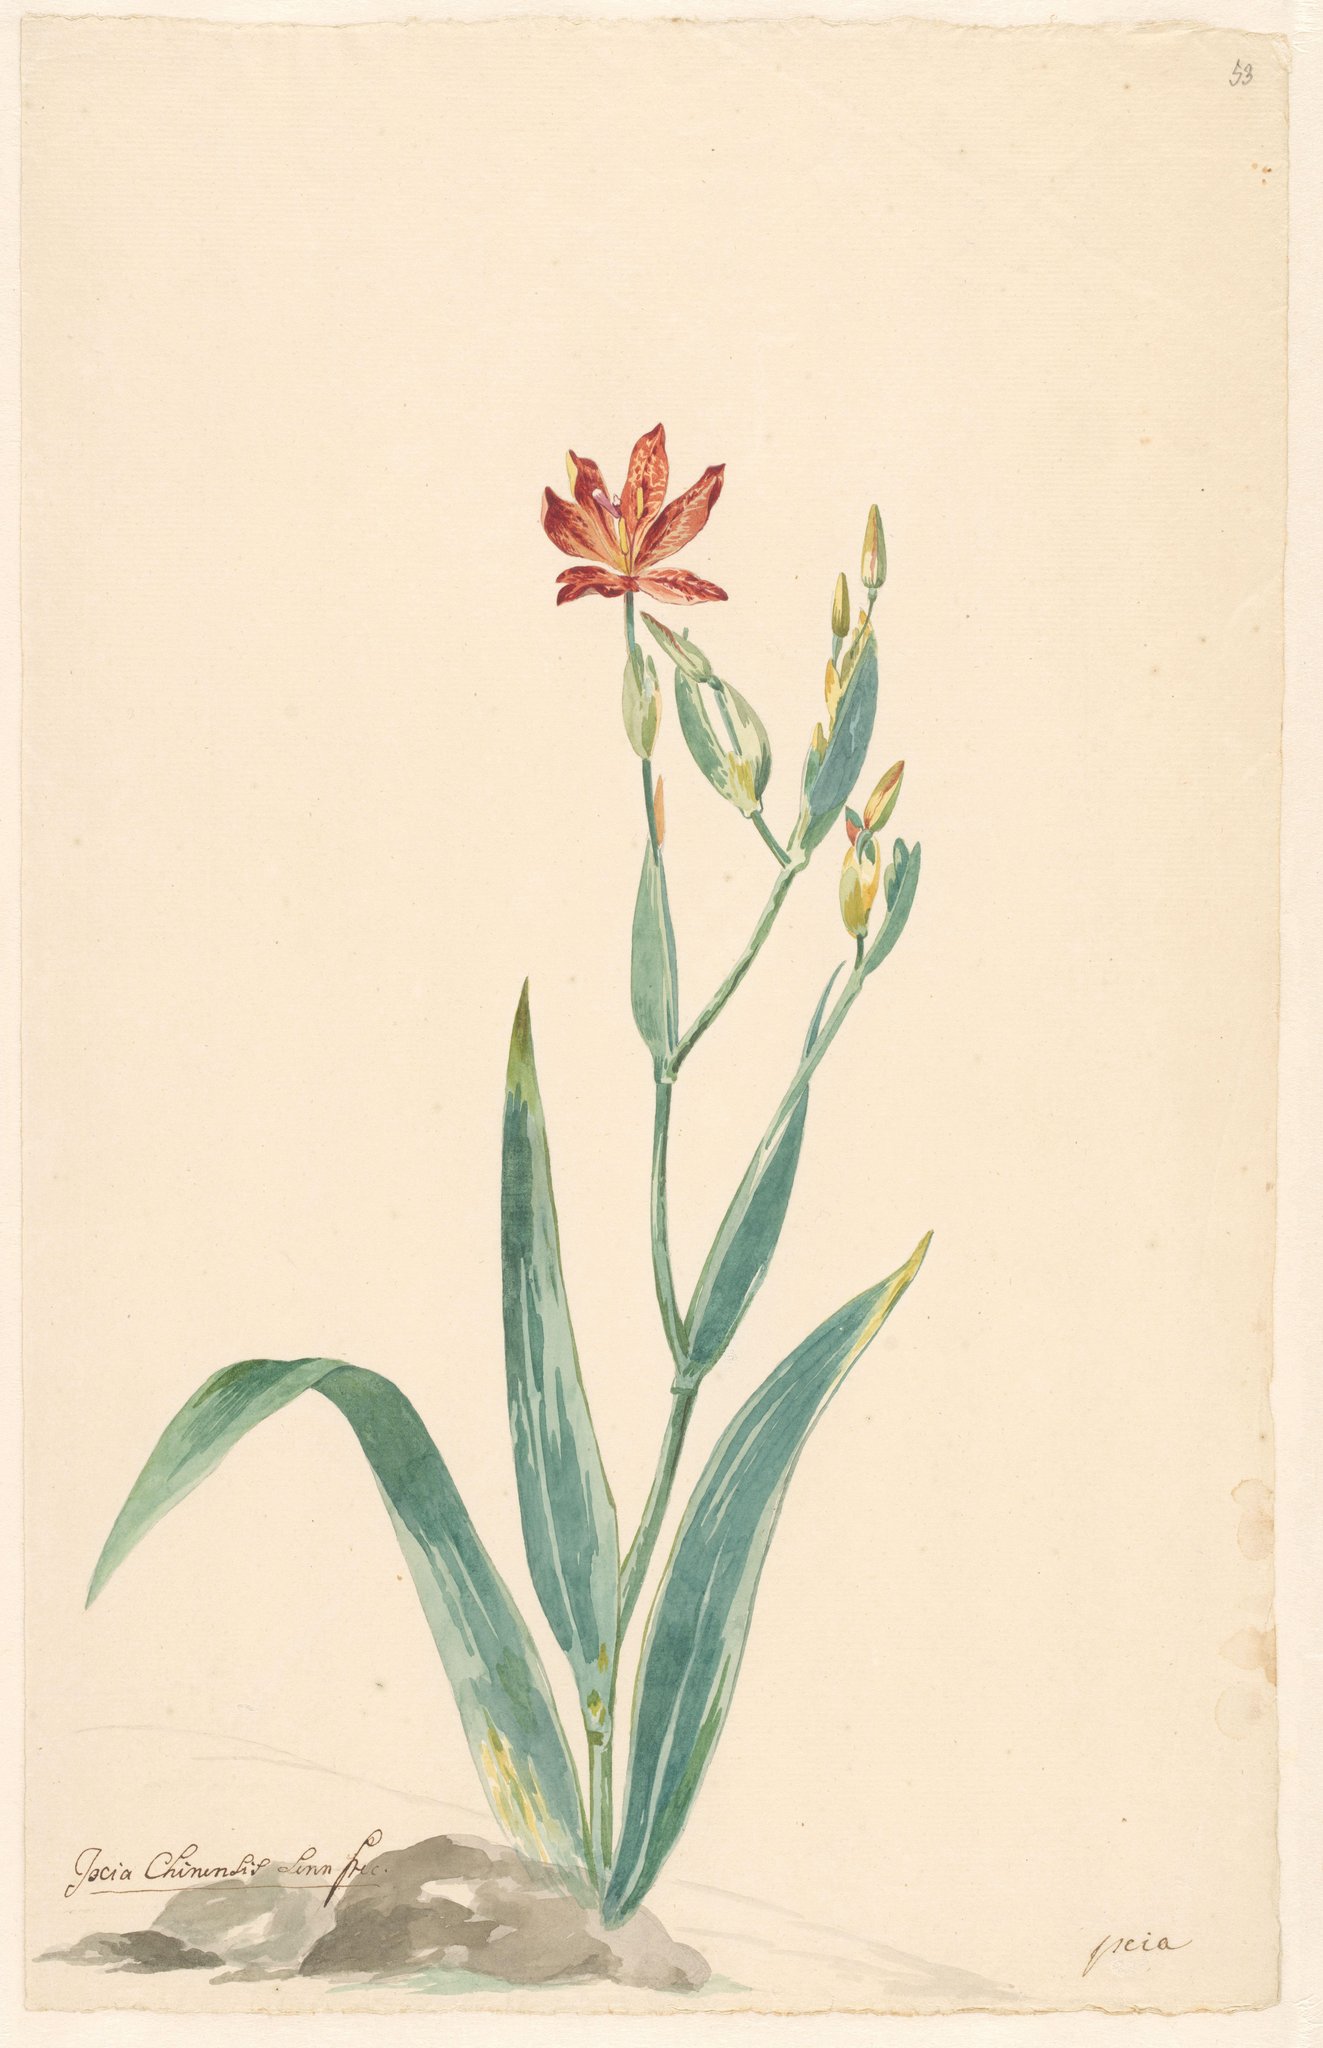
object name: drawing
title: Luipaardbloem in een landschap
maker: willem van leen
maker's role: draughtsman, print maker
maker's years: 1753-1825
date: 1775-1825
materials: gouache, pencil, watercolor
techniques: brush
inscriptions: annotation: ‘Jocia Chinensis Linn Spec.’, inscription: ‘53’